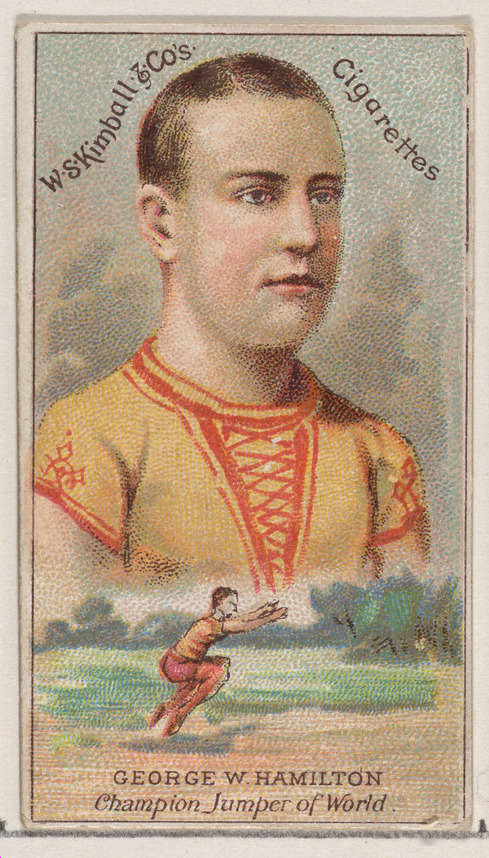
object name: print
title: George W. Hamilton, Champion Jumper of the World, from the Champions of Games and Sports series (N184, Type 1) issued by W.S. Kimball & Co.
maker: w.s. kimball & co.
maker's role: publisher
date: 1887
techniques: color lithograph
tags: men,sports,athletes